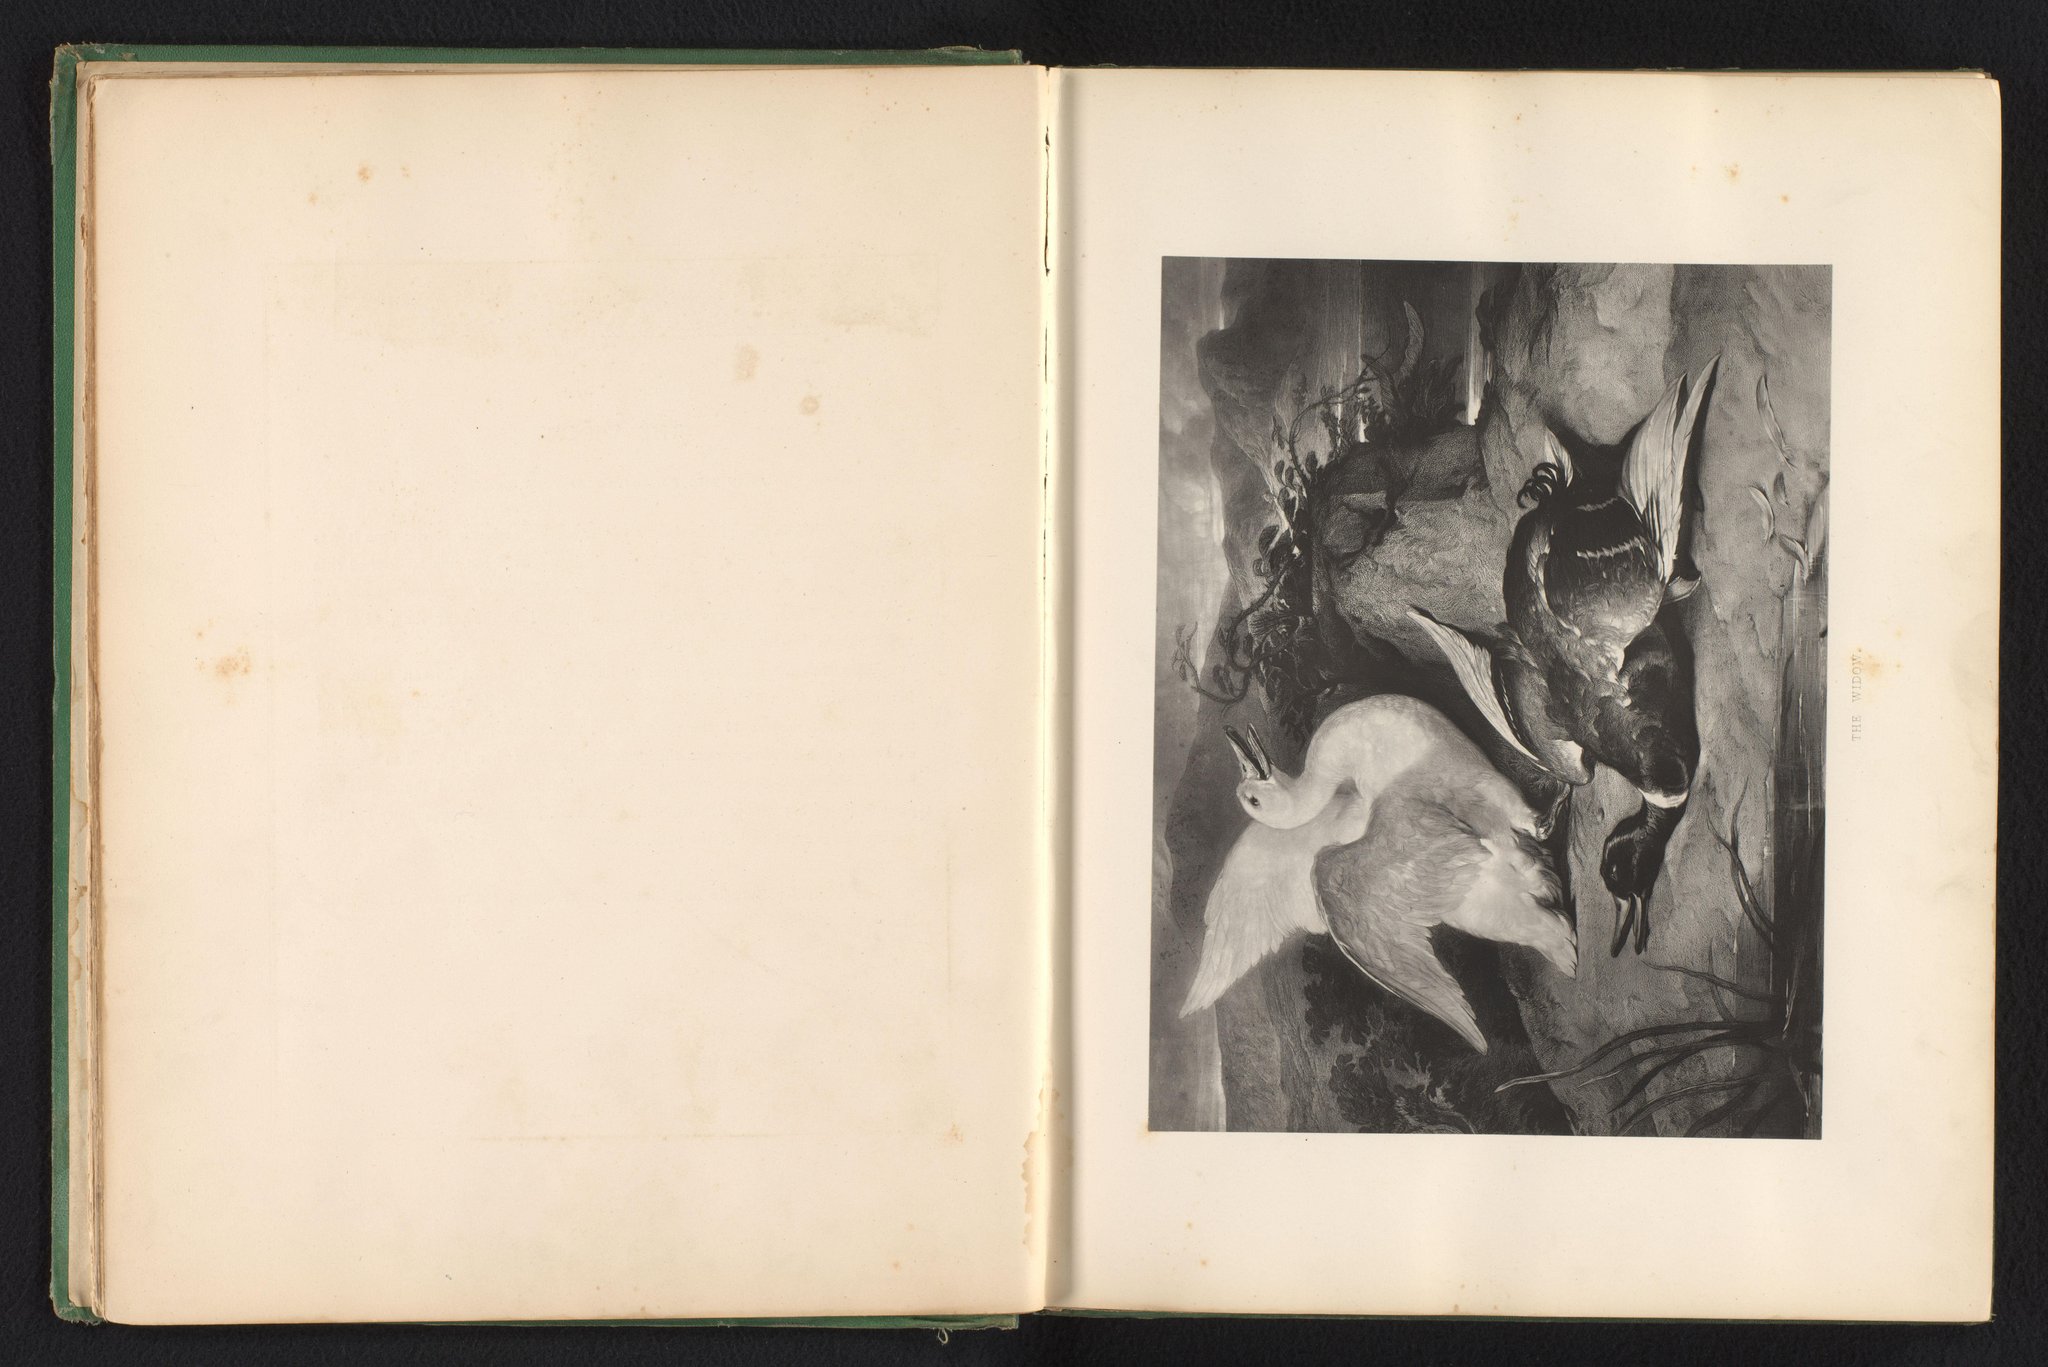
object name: photomechanical print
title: The widow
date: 1878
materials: paper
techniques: woodburytype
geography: london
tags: water-birds: duck